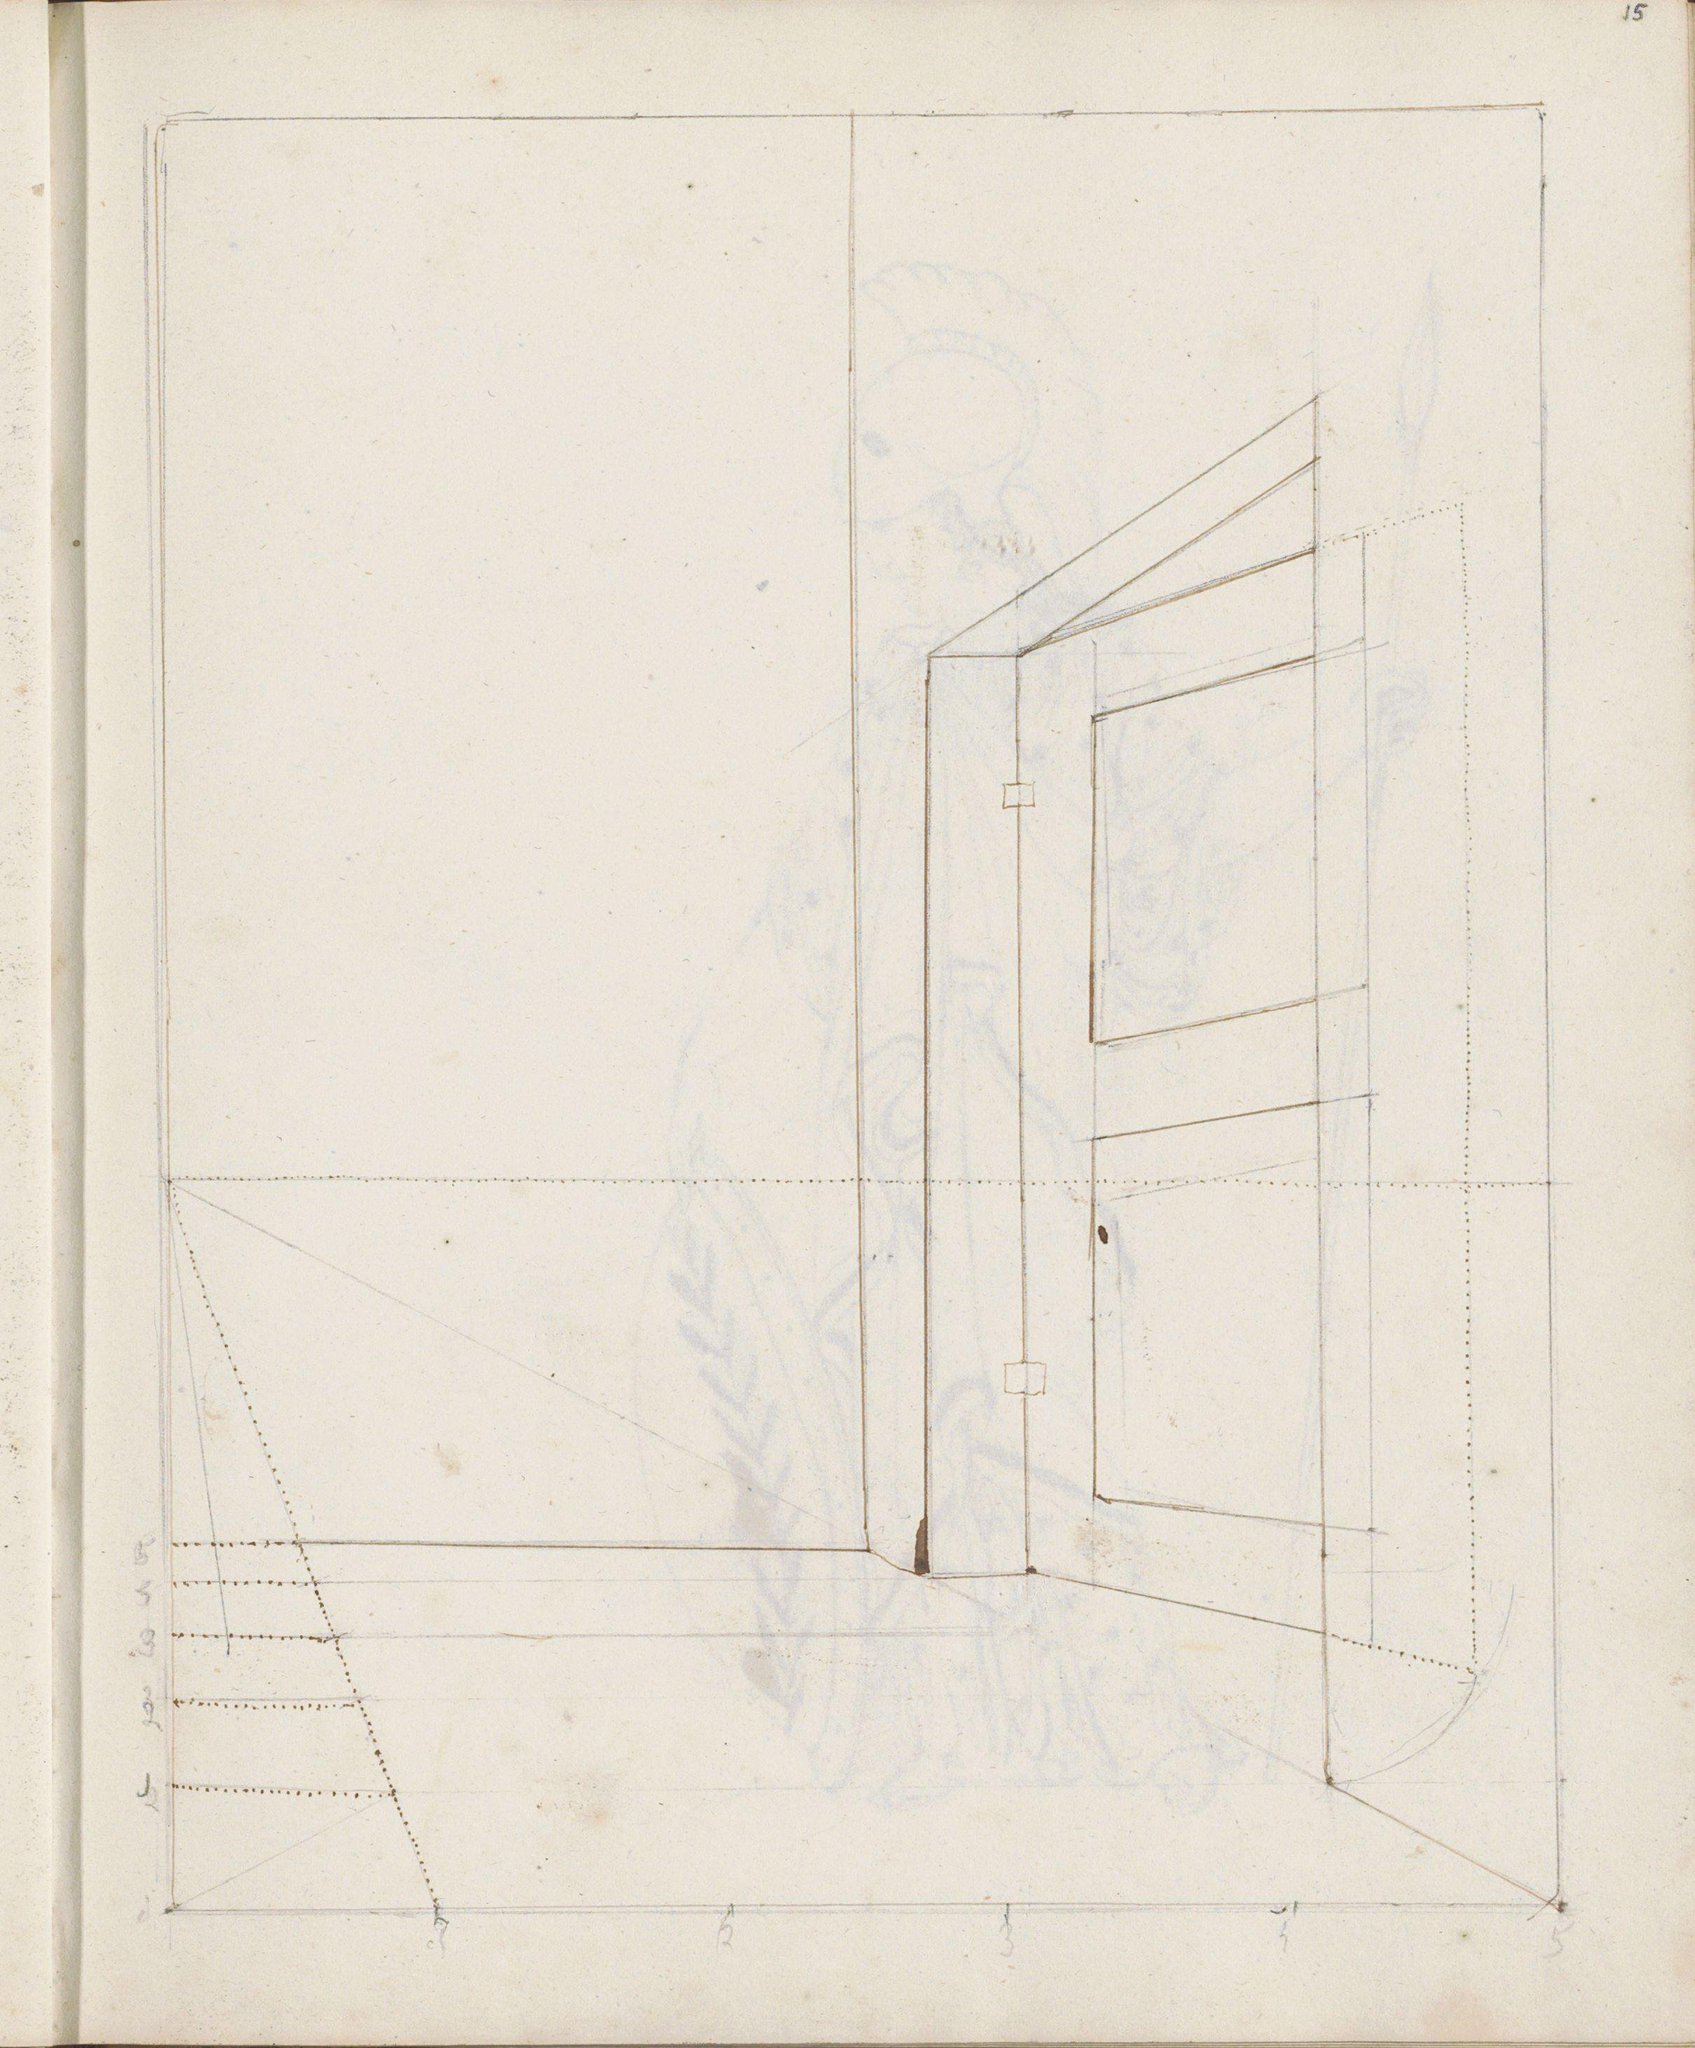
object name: sketchbook leaf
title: Perspectiefoefening met een open deur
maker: jonkvrouw catharina kemper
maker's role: draughtsman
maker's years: 1801-1871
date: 1813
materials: ink, paper, pencil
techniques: pen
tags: open door, mathematical perspective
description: Blad 15 recto uit een schetsboek met 91 bladen.